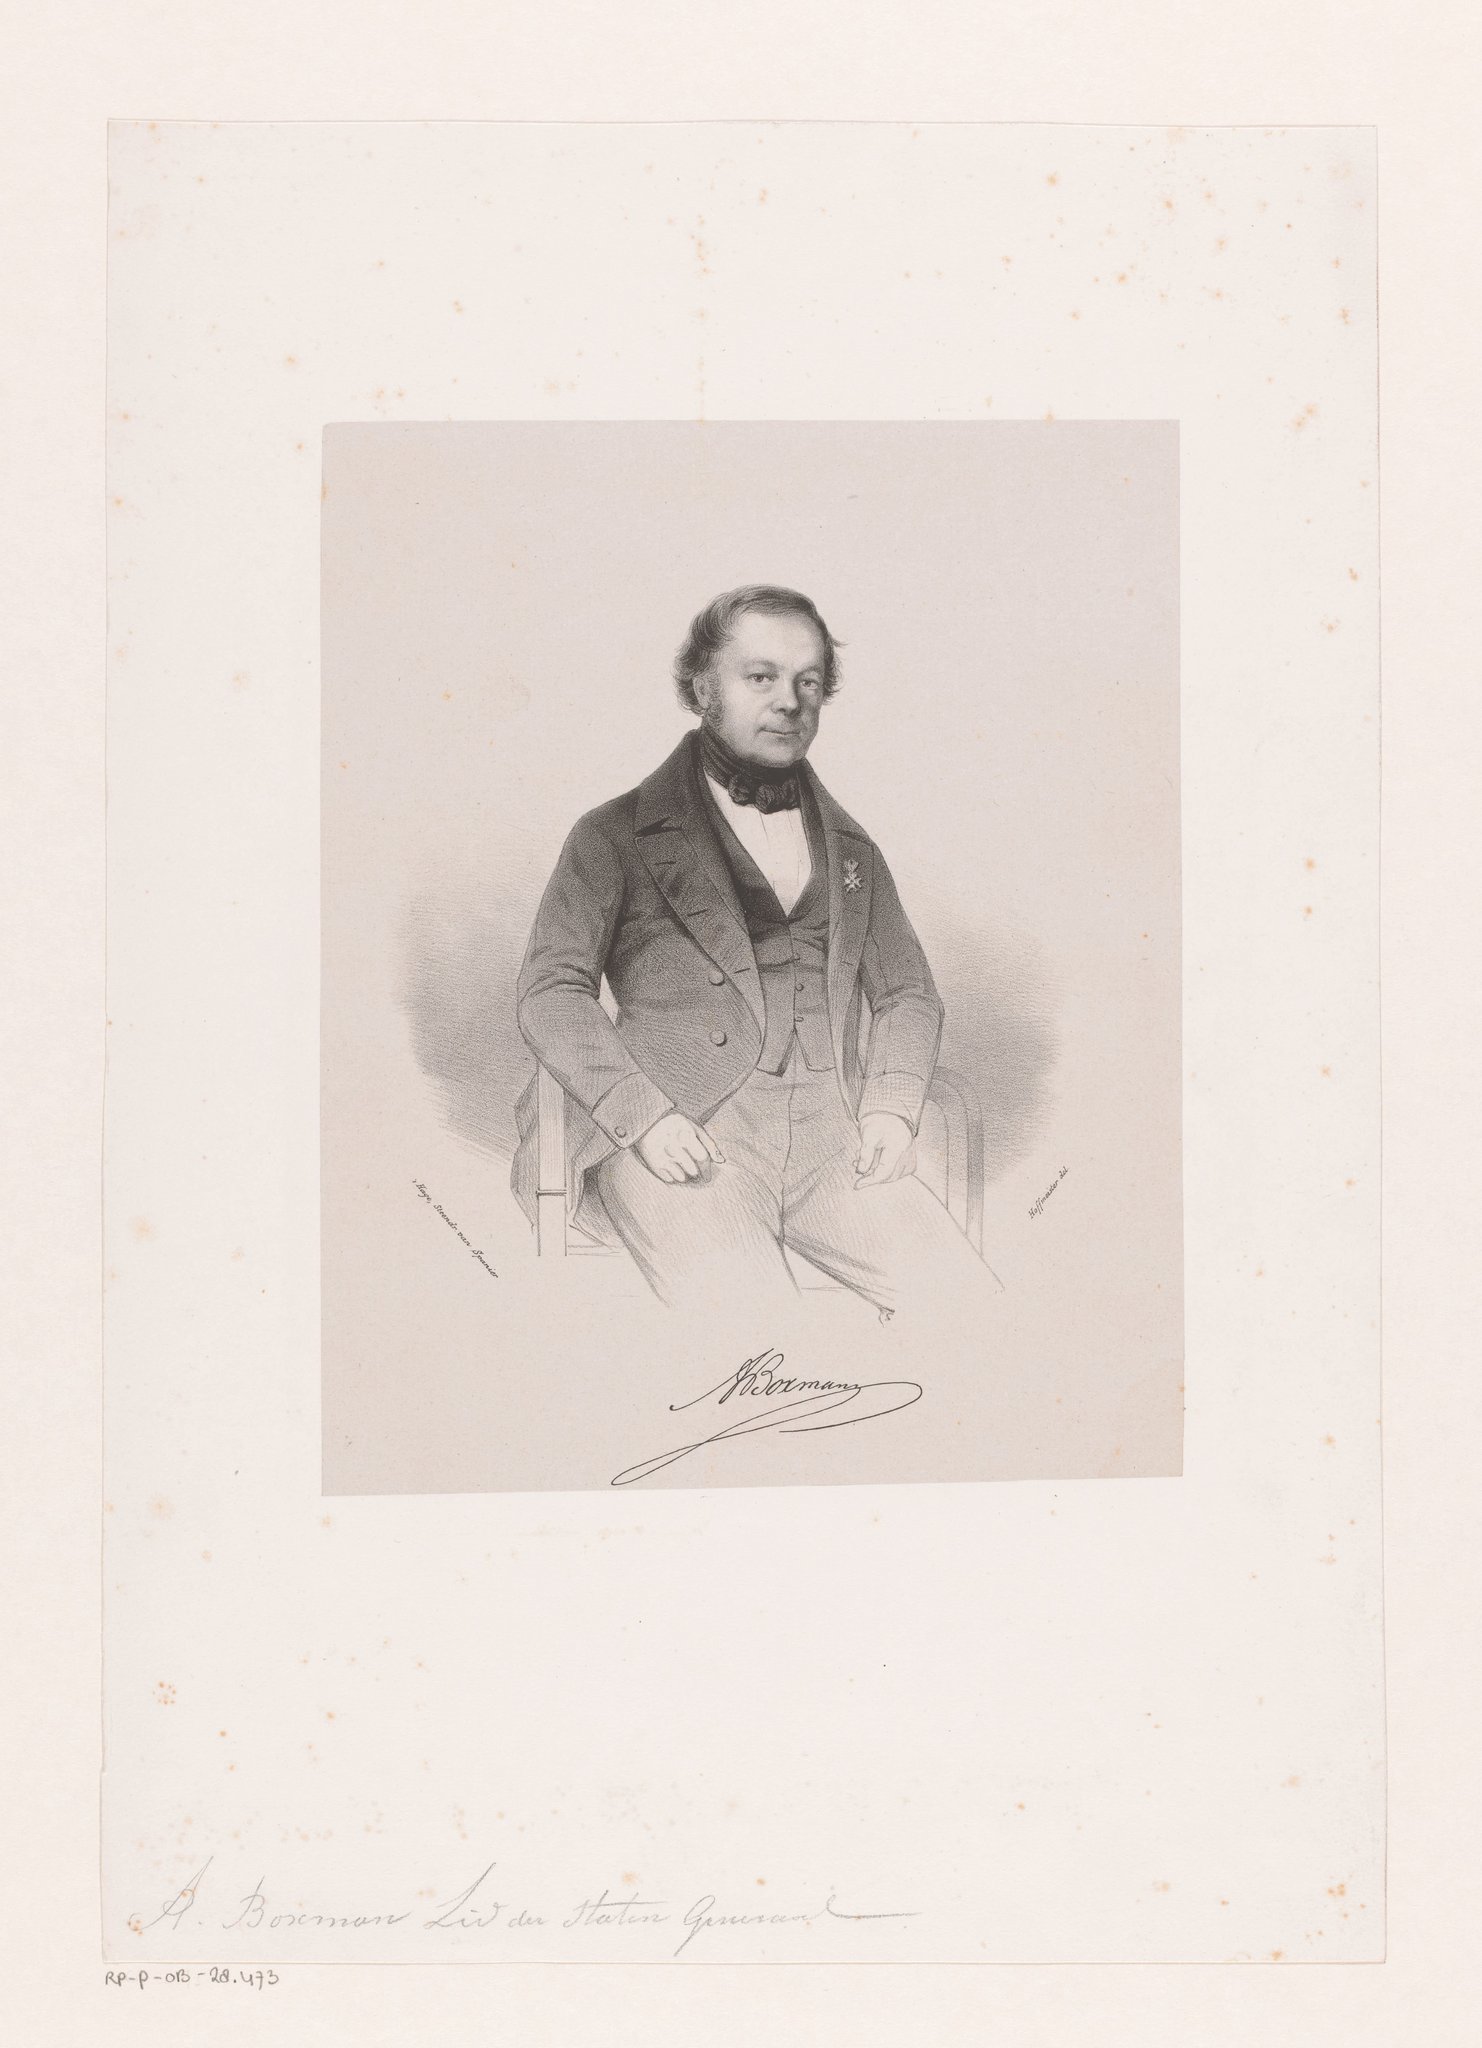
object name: print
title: Portret van Abraham Boxman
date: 1843-1856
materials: paper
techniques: lithograph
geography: the hague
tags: mayor, historical persons (+ three-quarter length portrait)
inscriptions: collector's mark: Lugt 2228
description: Onder het portret de signatuur van de geportretteerde.